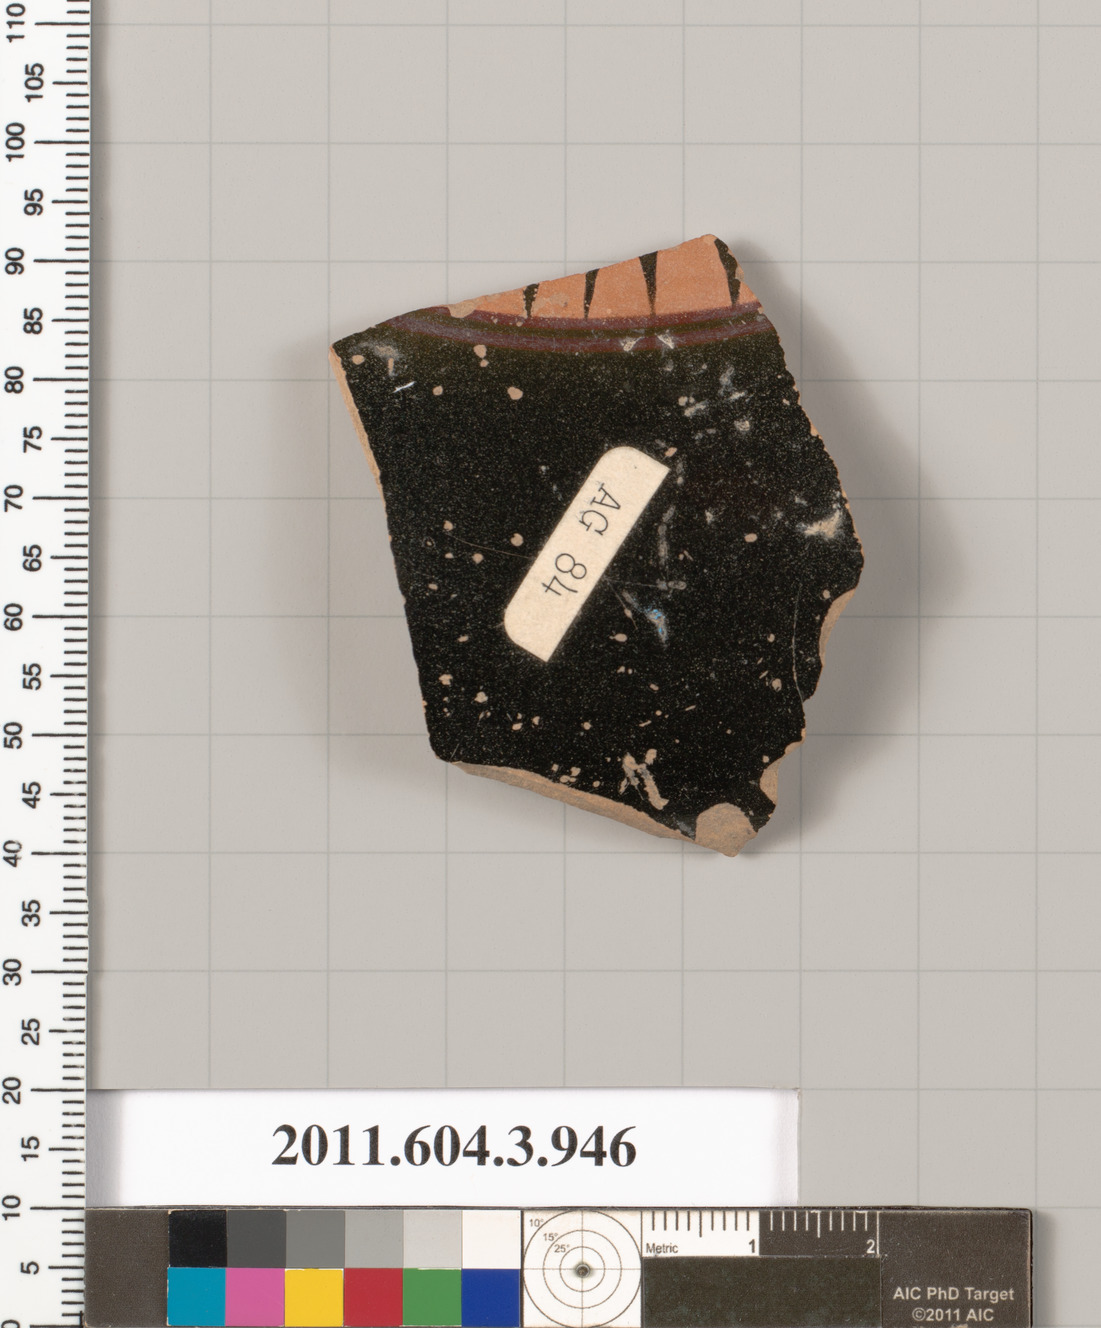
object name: lekanis lid fragment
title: Terracotta fragment of a lekanis lid (covered dish)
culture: greek, attic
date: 600-501 BCE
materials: terracotta